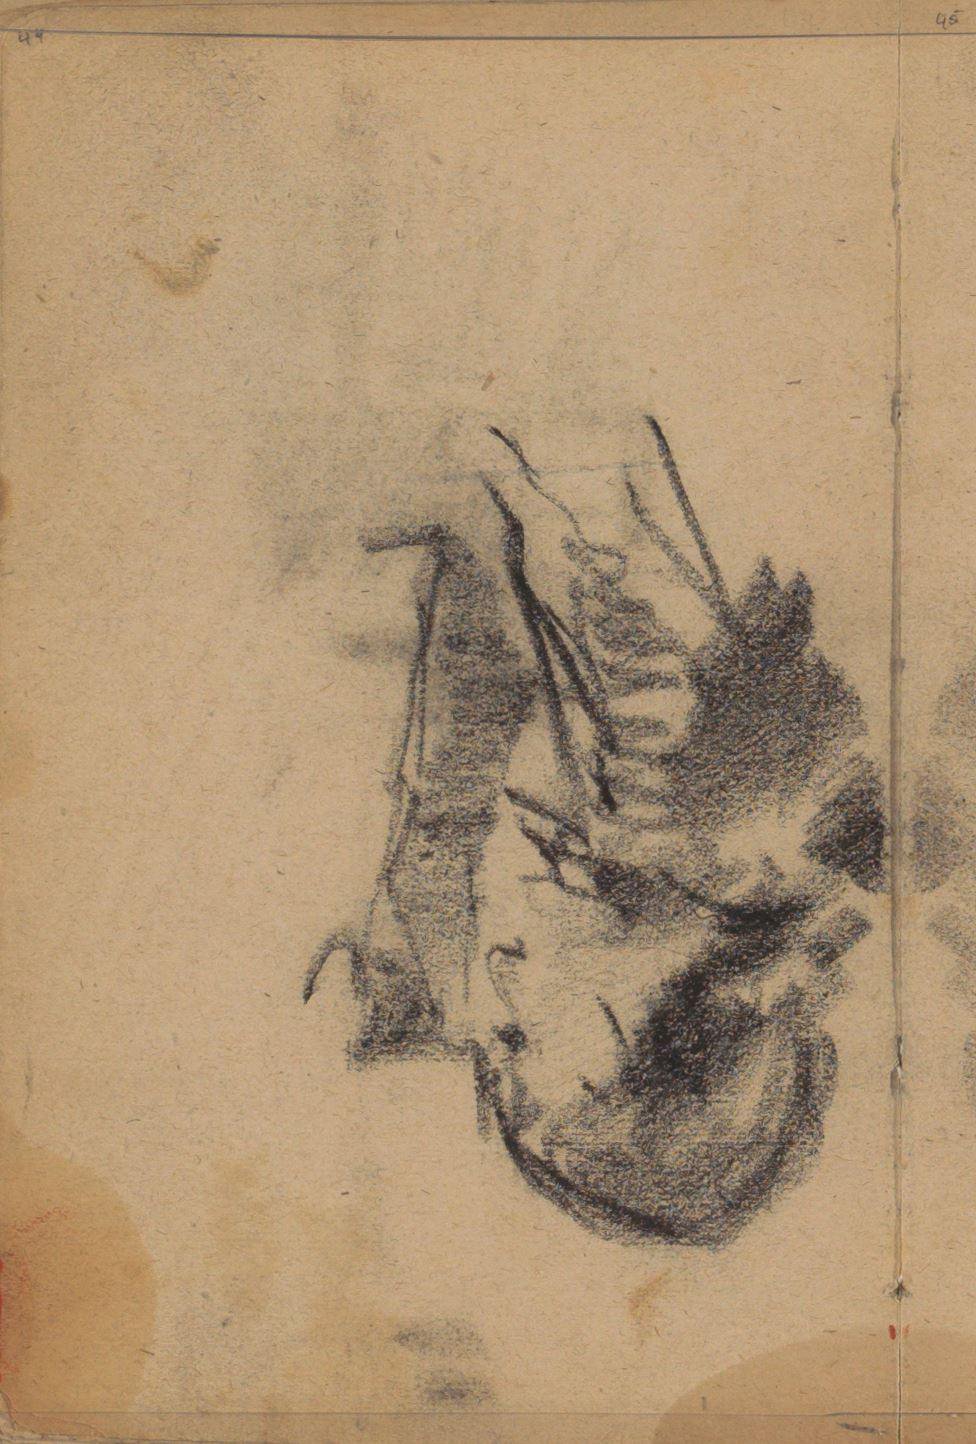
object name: sketchbook leaf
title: Figuurstudie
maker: george hendrik breitner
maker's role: draughtsman, painter, print maker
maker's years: 1857-1923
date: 1881-1883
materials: chalk, paper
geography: south holland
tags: man in a general biological sense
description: Figuur, in profiel naar rechts. Pagina 44 uit een schetsboek met 70 bladen.